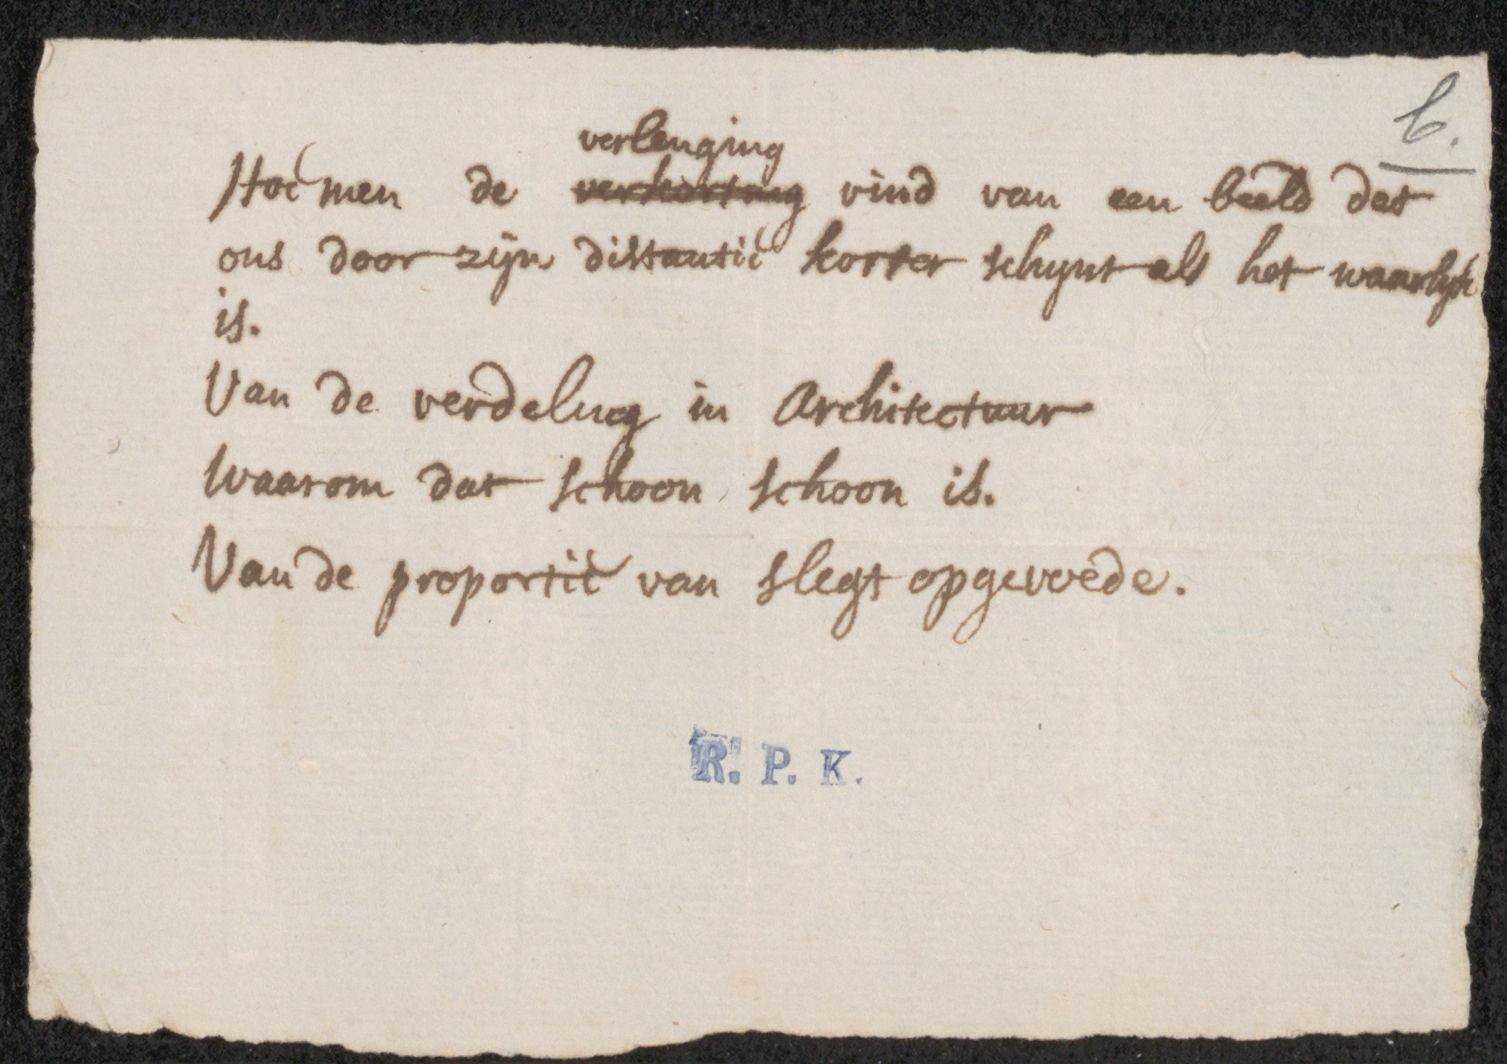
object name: aantekening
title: Aantekening betreffende punten van studie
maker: jacob willemsz. delff (ii)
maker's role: painter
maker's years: 1619-1661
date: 1629-1661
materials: ink, paper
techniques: pen, writing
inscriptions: collector's mark: Lugt 2233